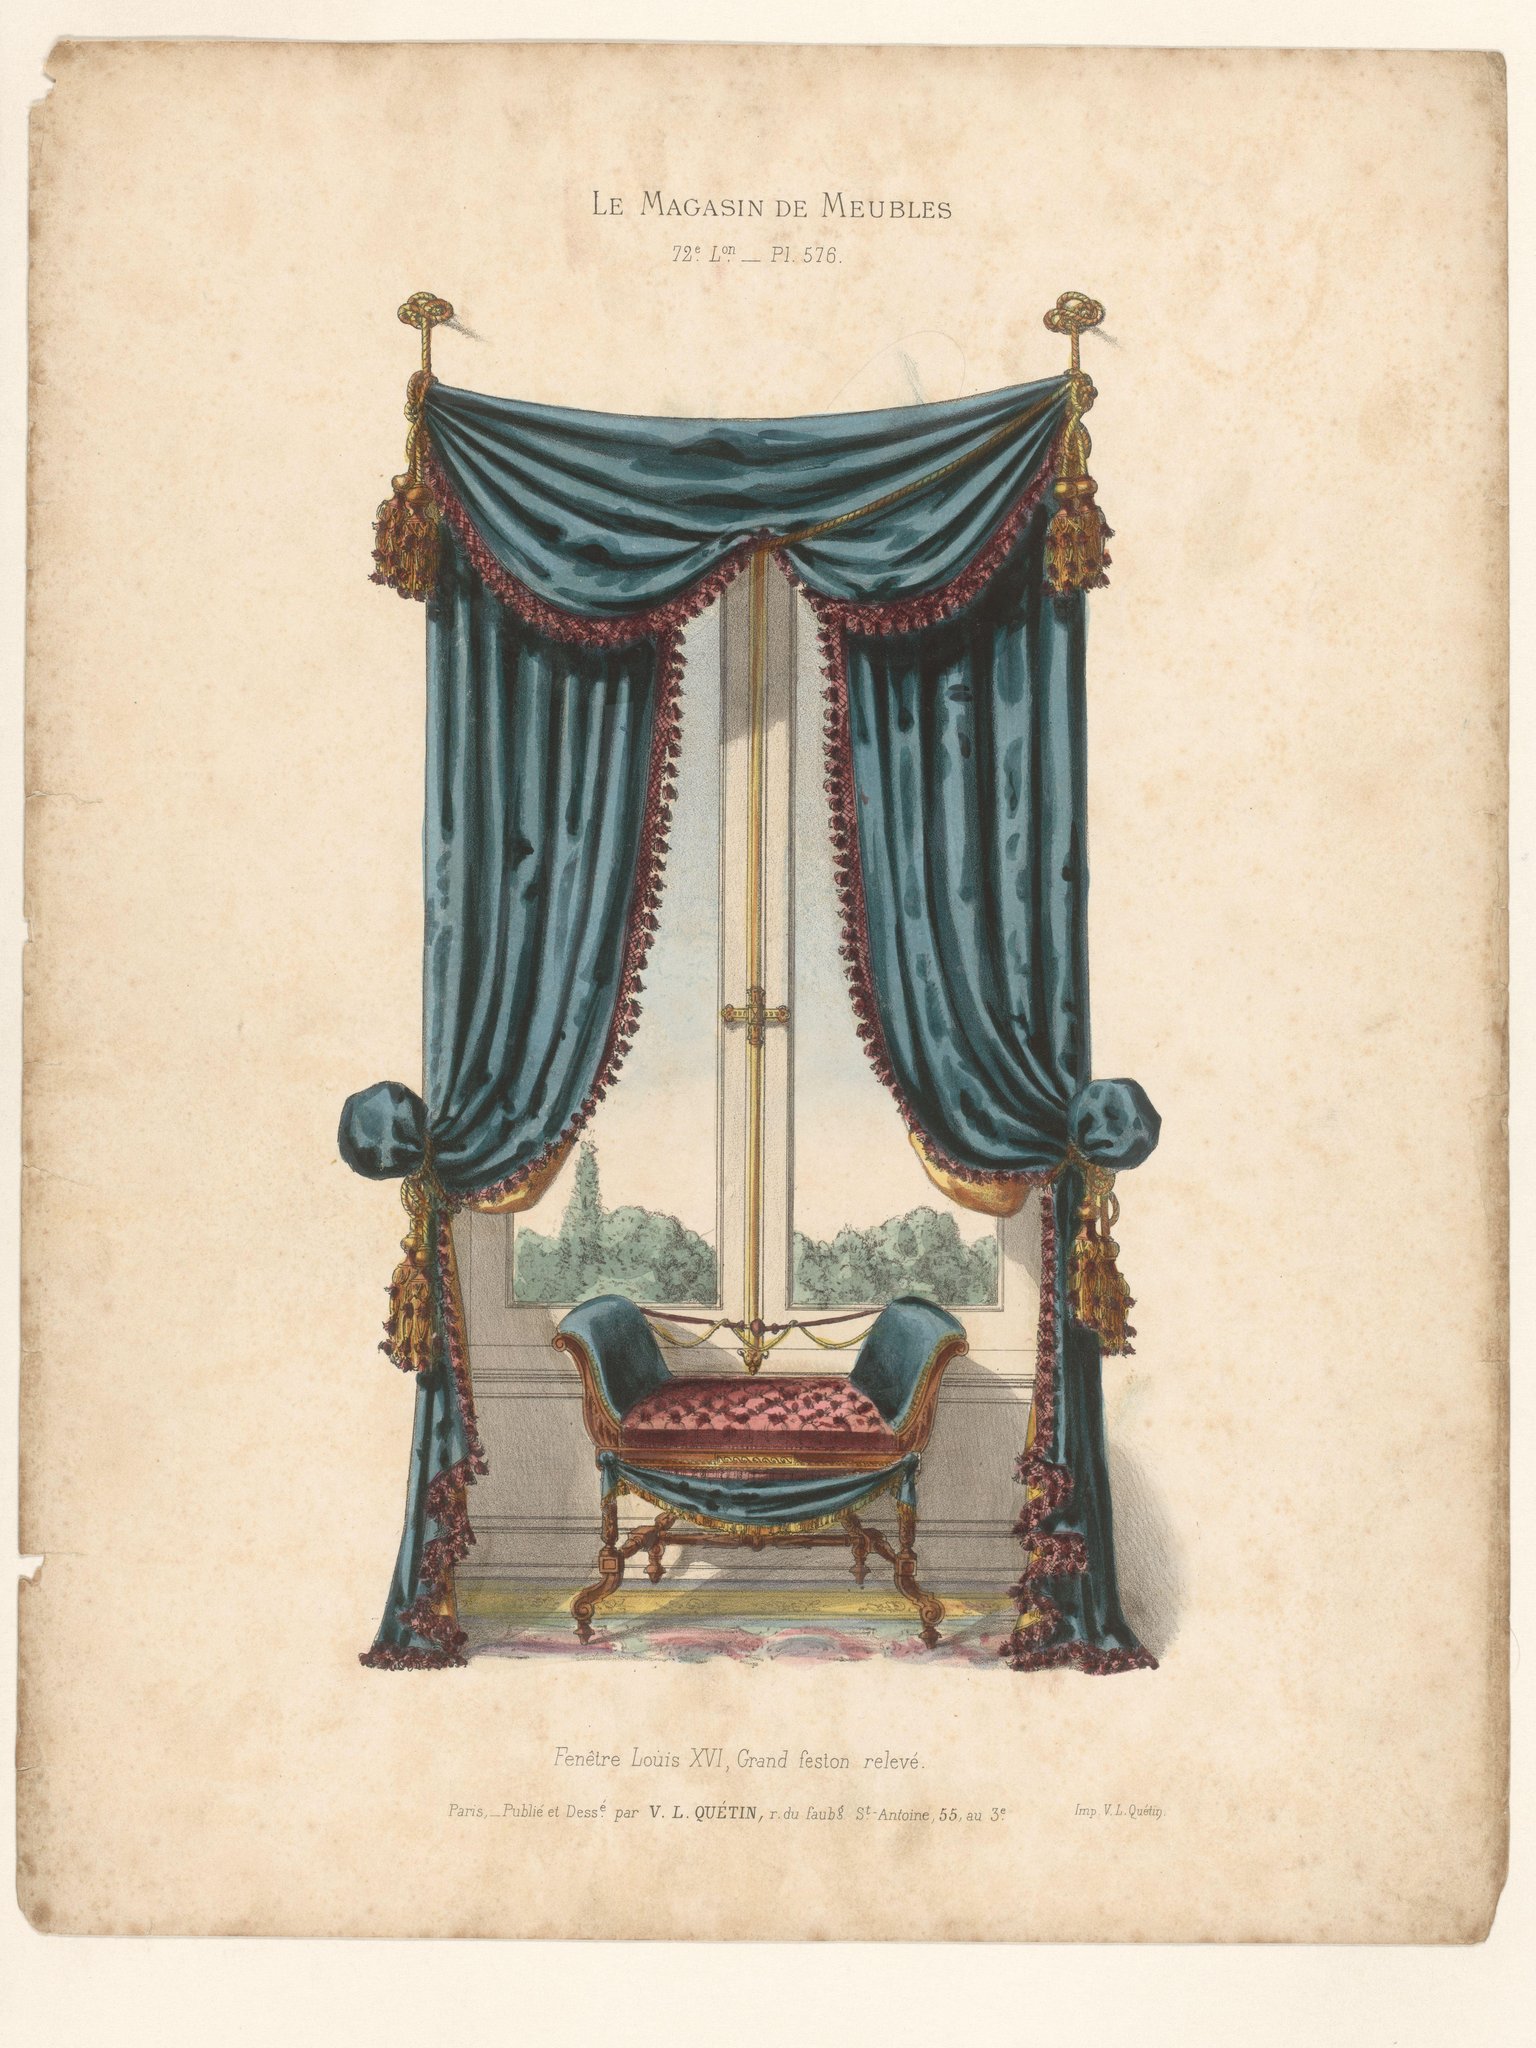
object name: print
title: Le Magasin de Meubles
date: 1878-1904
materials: paper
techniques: hand coloring, lithograph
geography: paris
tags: window, hangings and drapery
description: Een venster met gedrapeerde gordijnen in de Lodewijk XVI-stijl. Voor het venster staat een zitmeubel. Prent uit 72e Livraison.